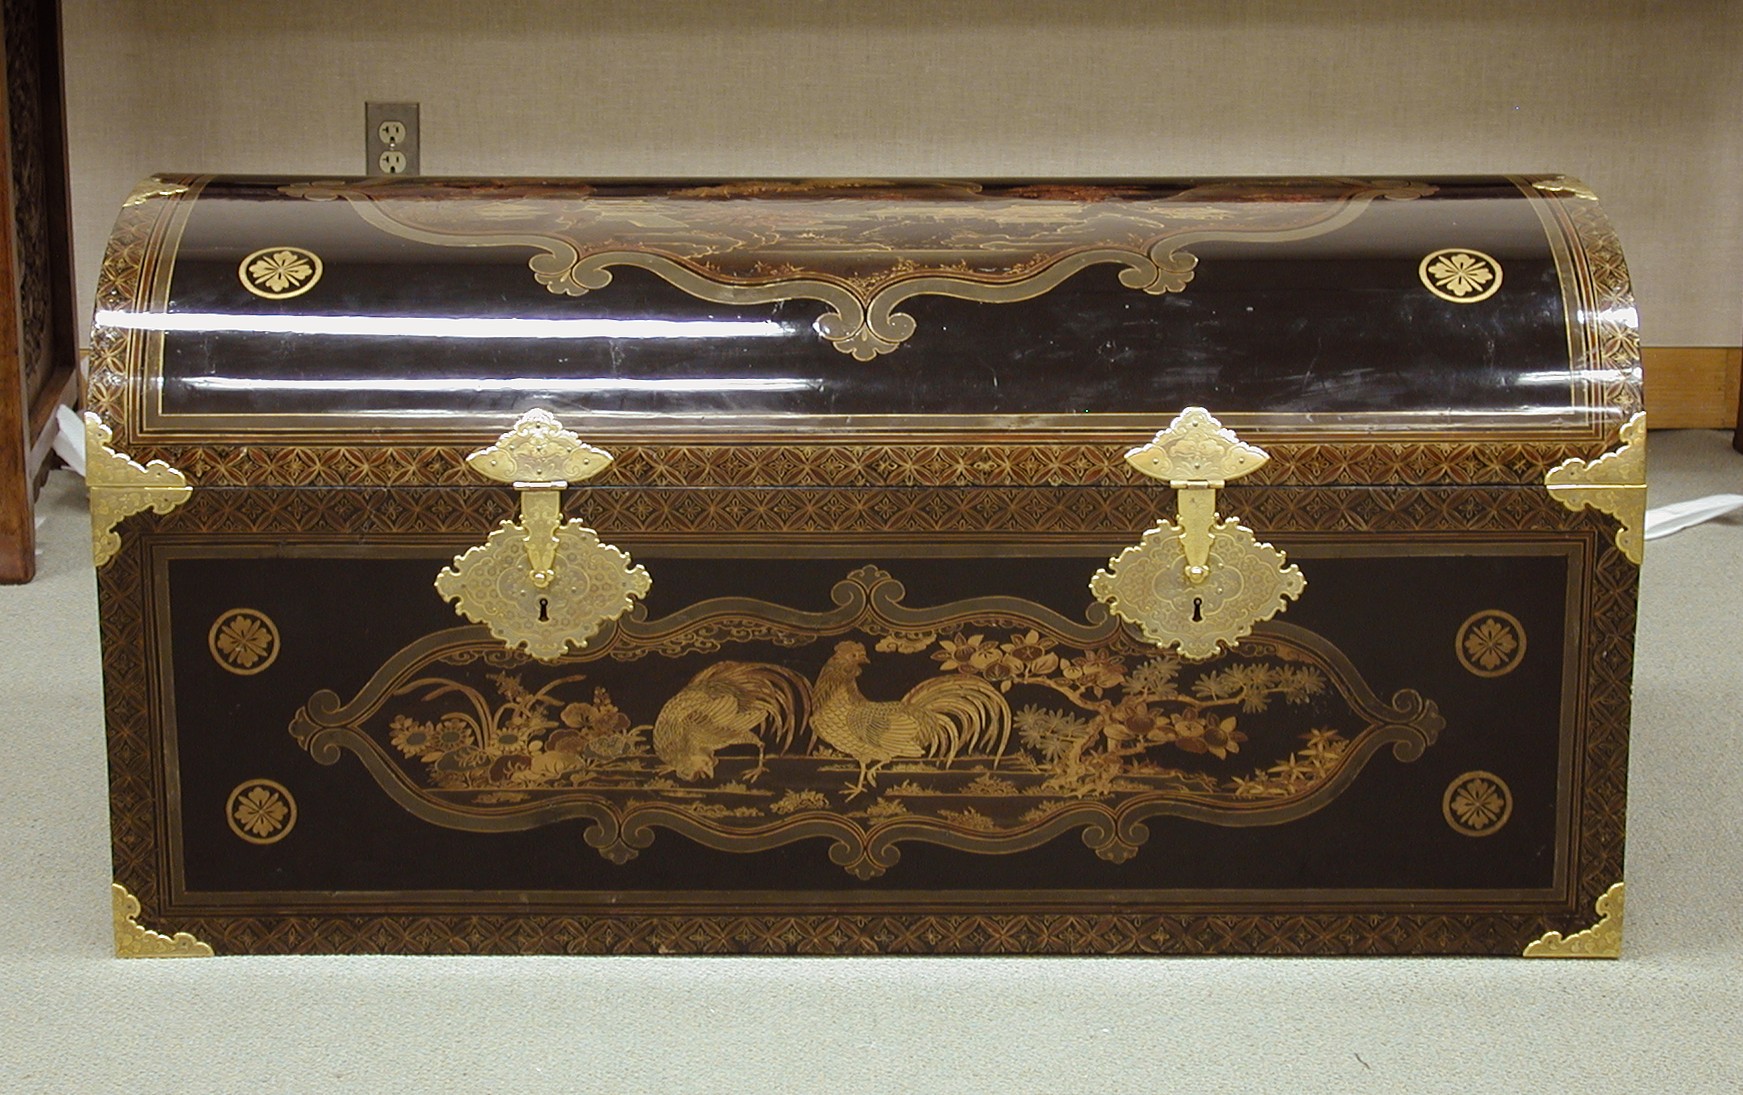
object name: coffer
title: Coffer in Nanban (Southern Barbarian) Style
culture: japanese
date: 1701-1800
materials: gold, lacquer, wood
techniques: painting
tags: roosters,trees